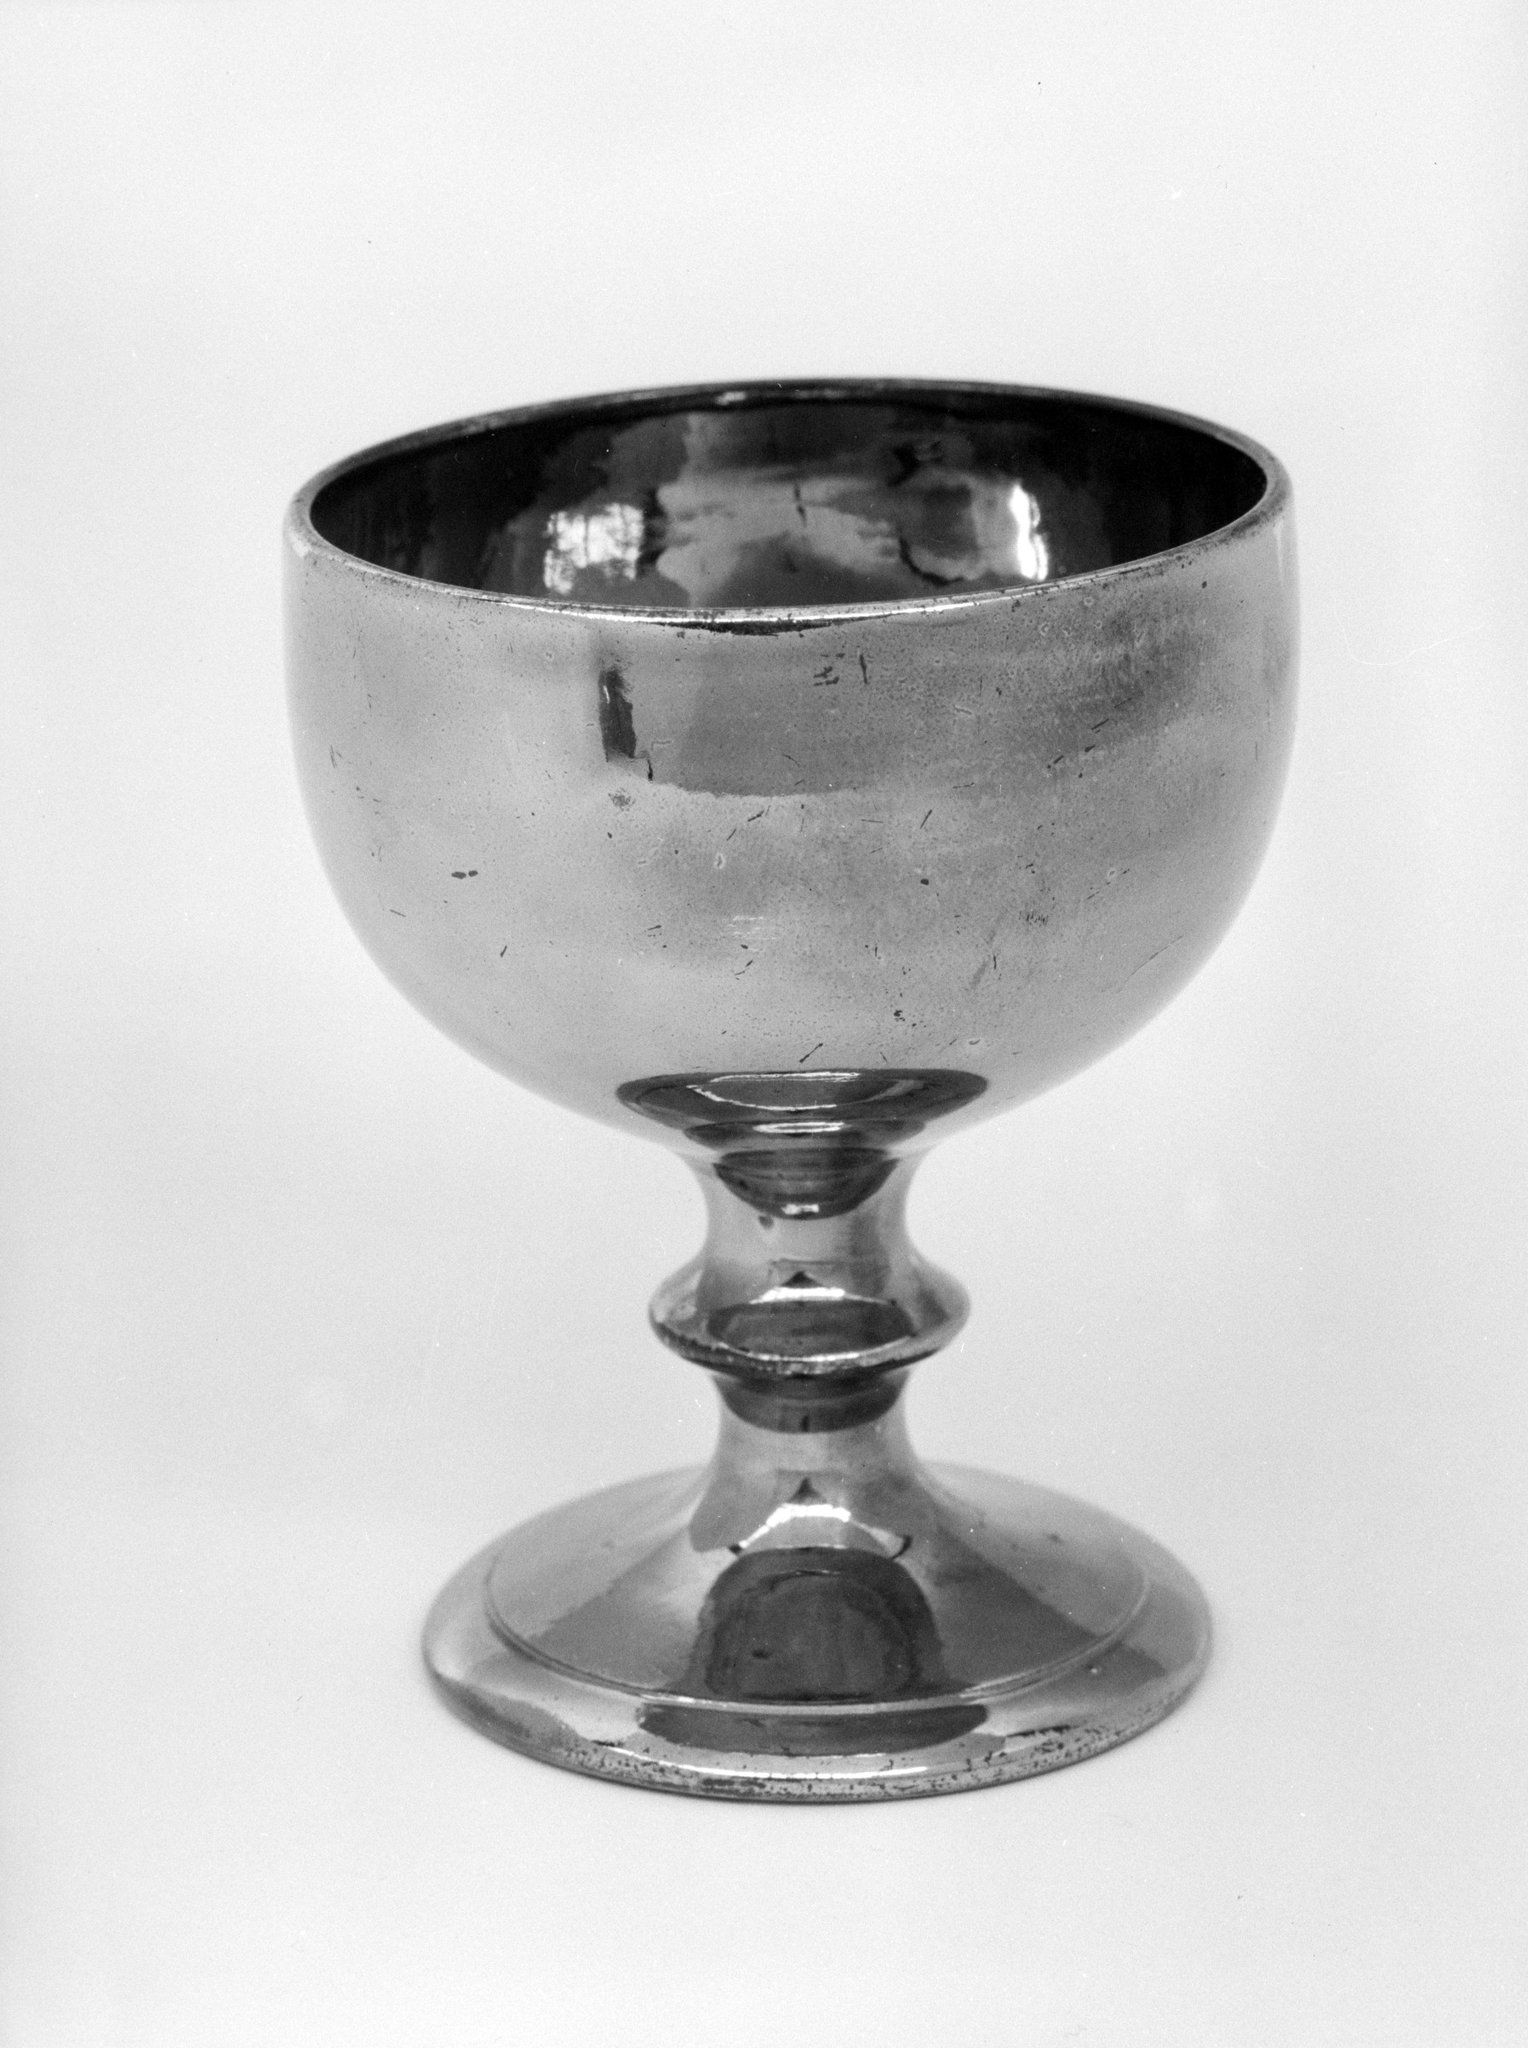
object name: goblet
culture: british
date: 1800-1830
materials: earthenware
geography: england